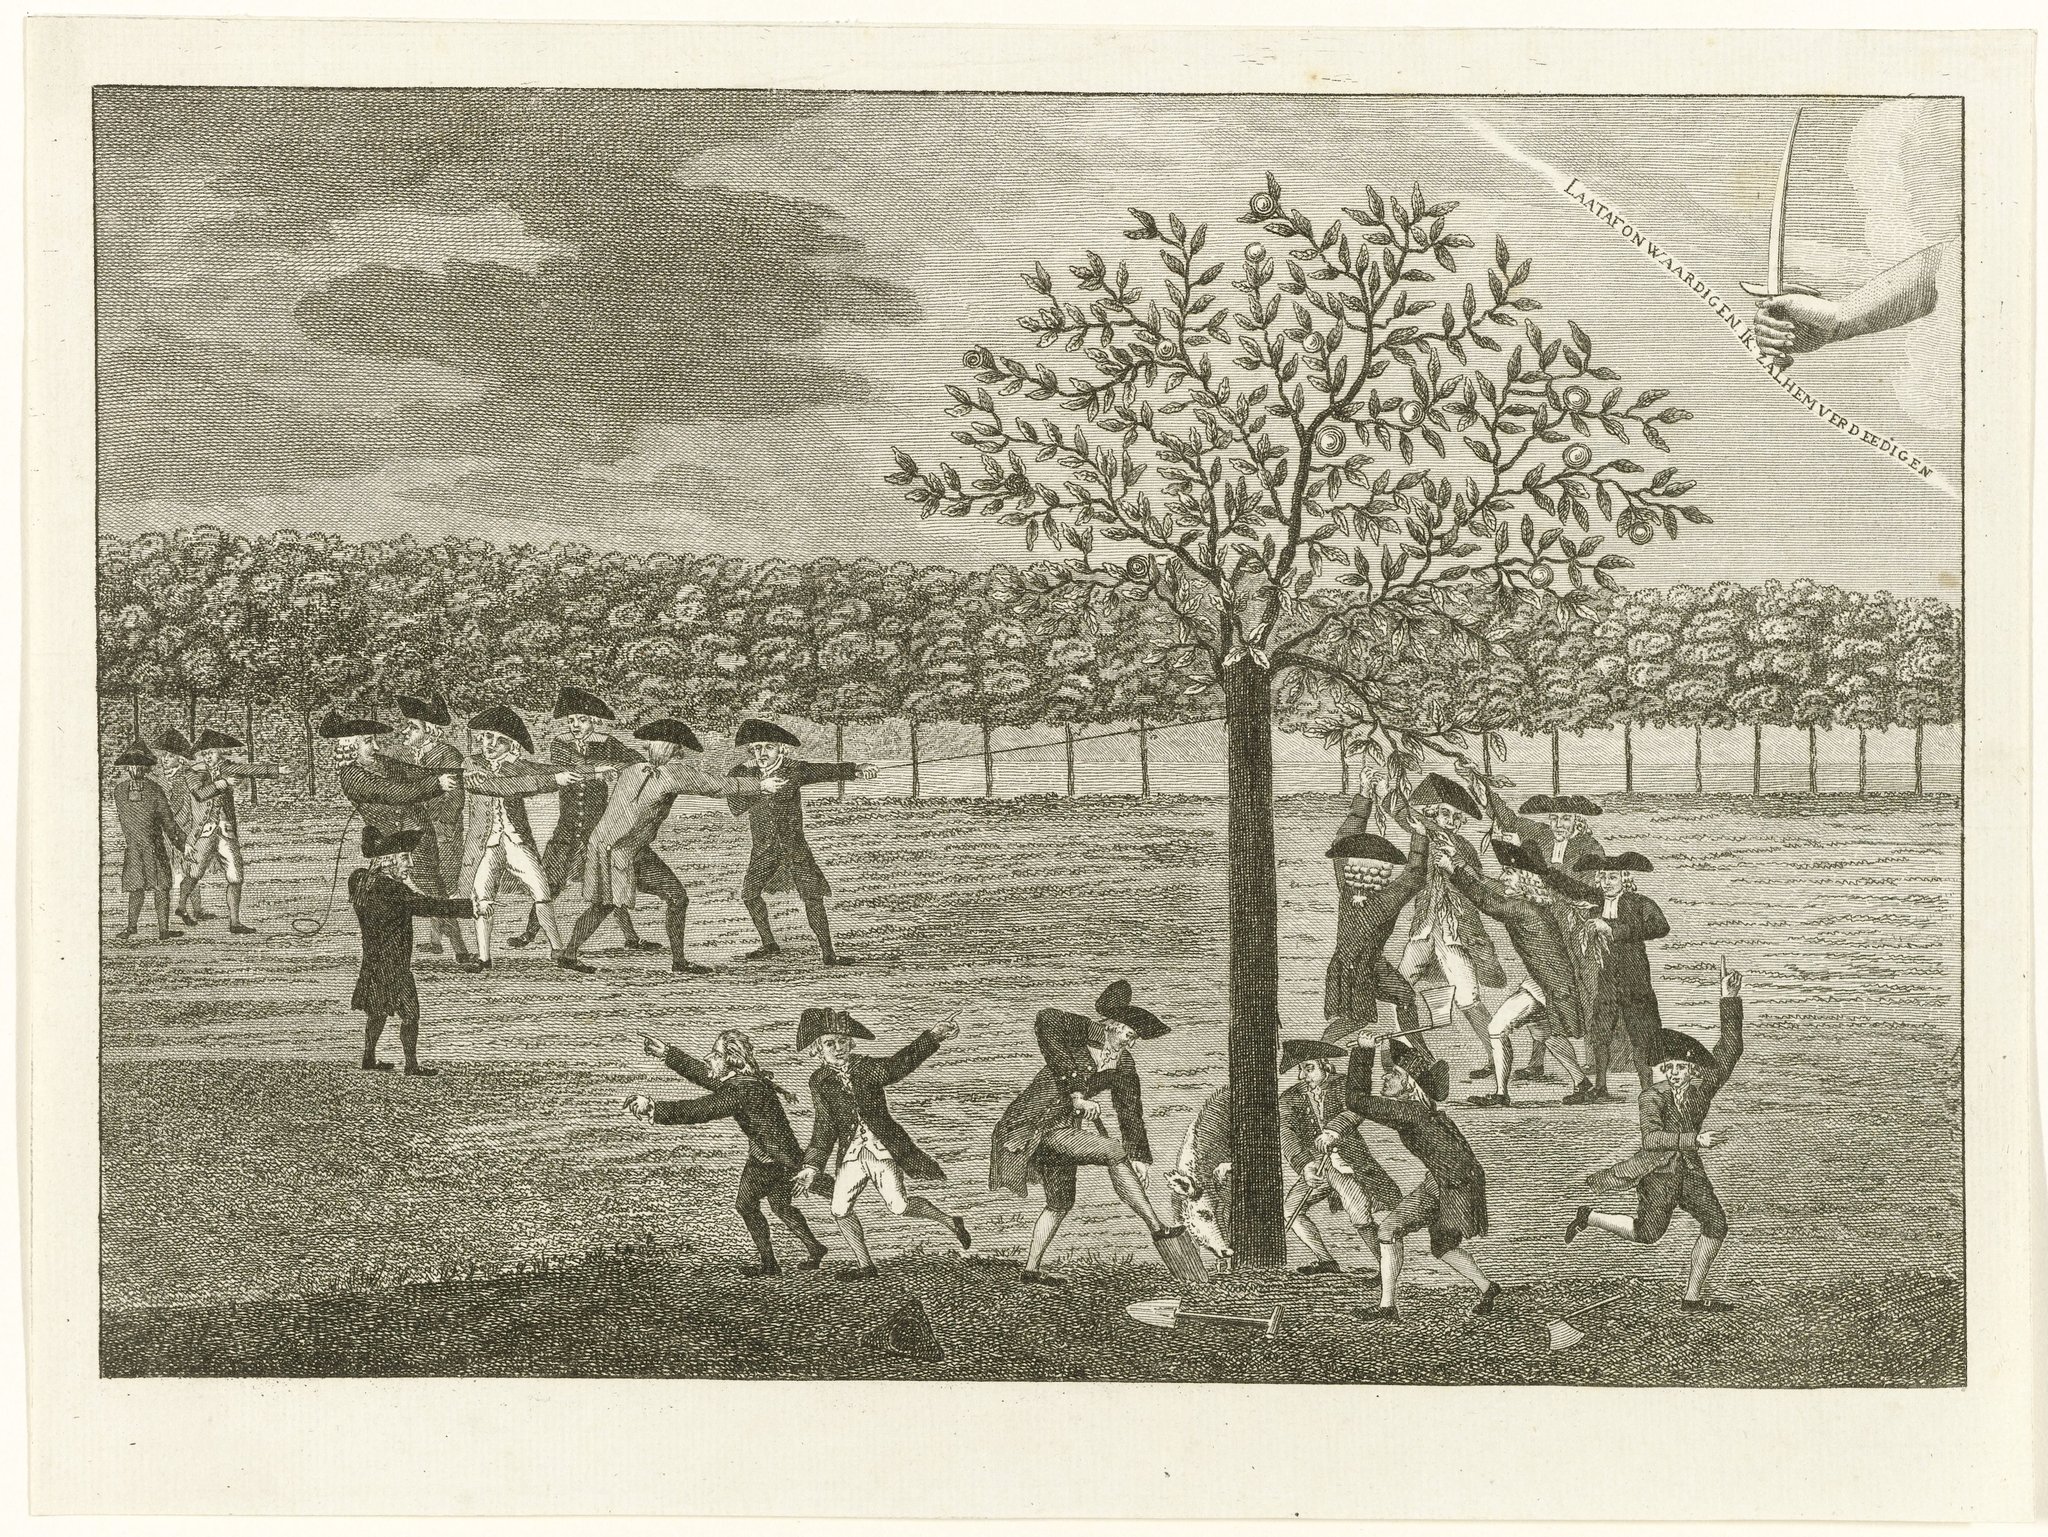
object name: print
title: Spotprent op de pogingen de Oranjeboom omver te trekken, 1787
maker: Anonymous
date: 1787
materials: paper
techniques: engraving, etching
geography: northern netherlands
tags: william v (prince of orange), patriots (1780-1795)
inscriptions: collector's mark: Lugt 2228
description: Spotprent op de vergeefse pogingen van de patriotten om de Oranjeboom omver te trekken, 1787. Groepen patriotten proberen de boom omver te trekken, de wortels uit te graven en takken af te breken. Rechts verschijnt uit de wolken de arm van God met zwaard in de hand die de boom zal verdedigen en die waarschuwt de pogingen te staken. Het zwijn achter de stam verwijst naar de domheid van de ondermijners. Bij de prent behoort een blad met verklaring. Bij de prent ook een handgeschreven afschrift van de langere verklaring in de collectie van de Atlas van Stolk.